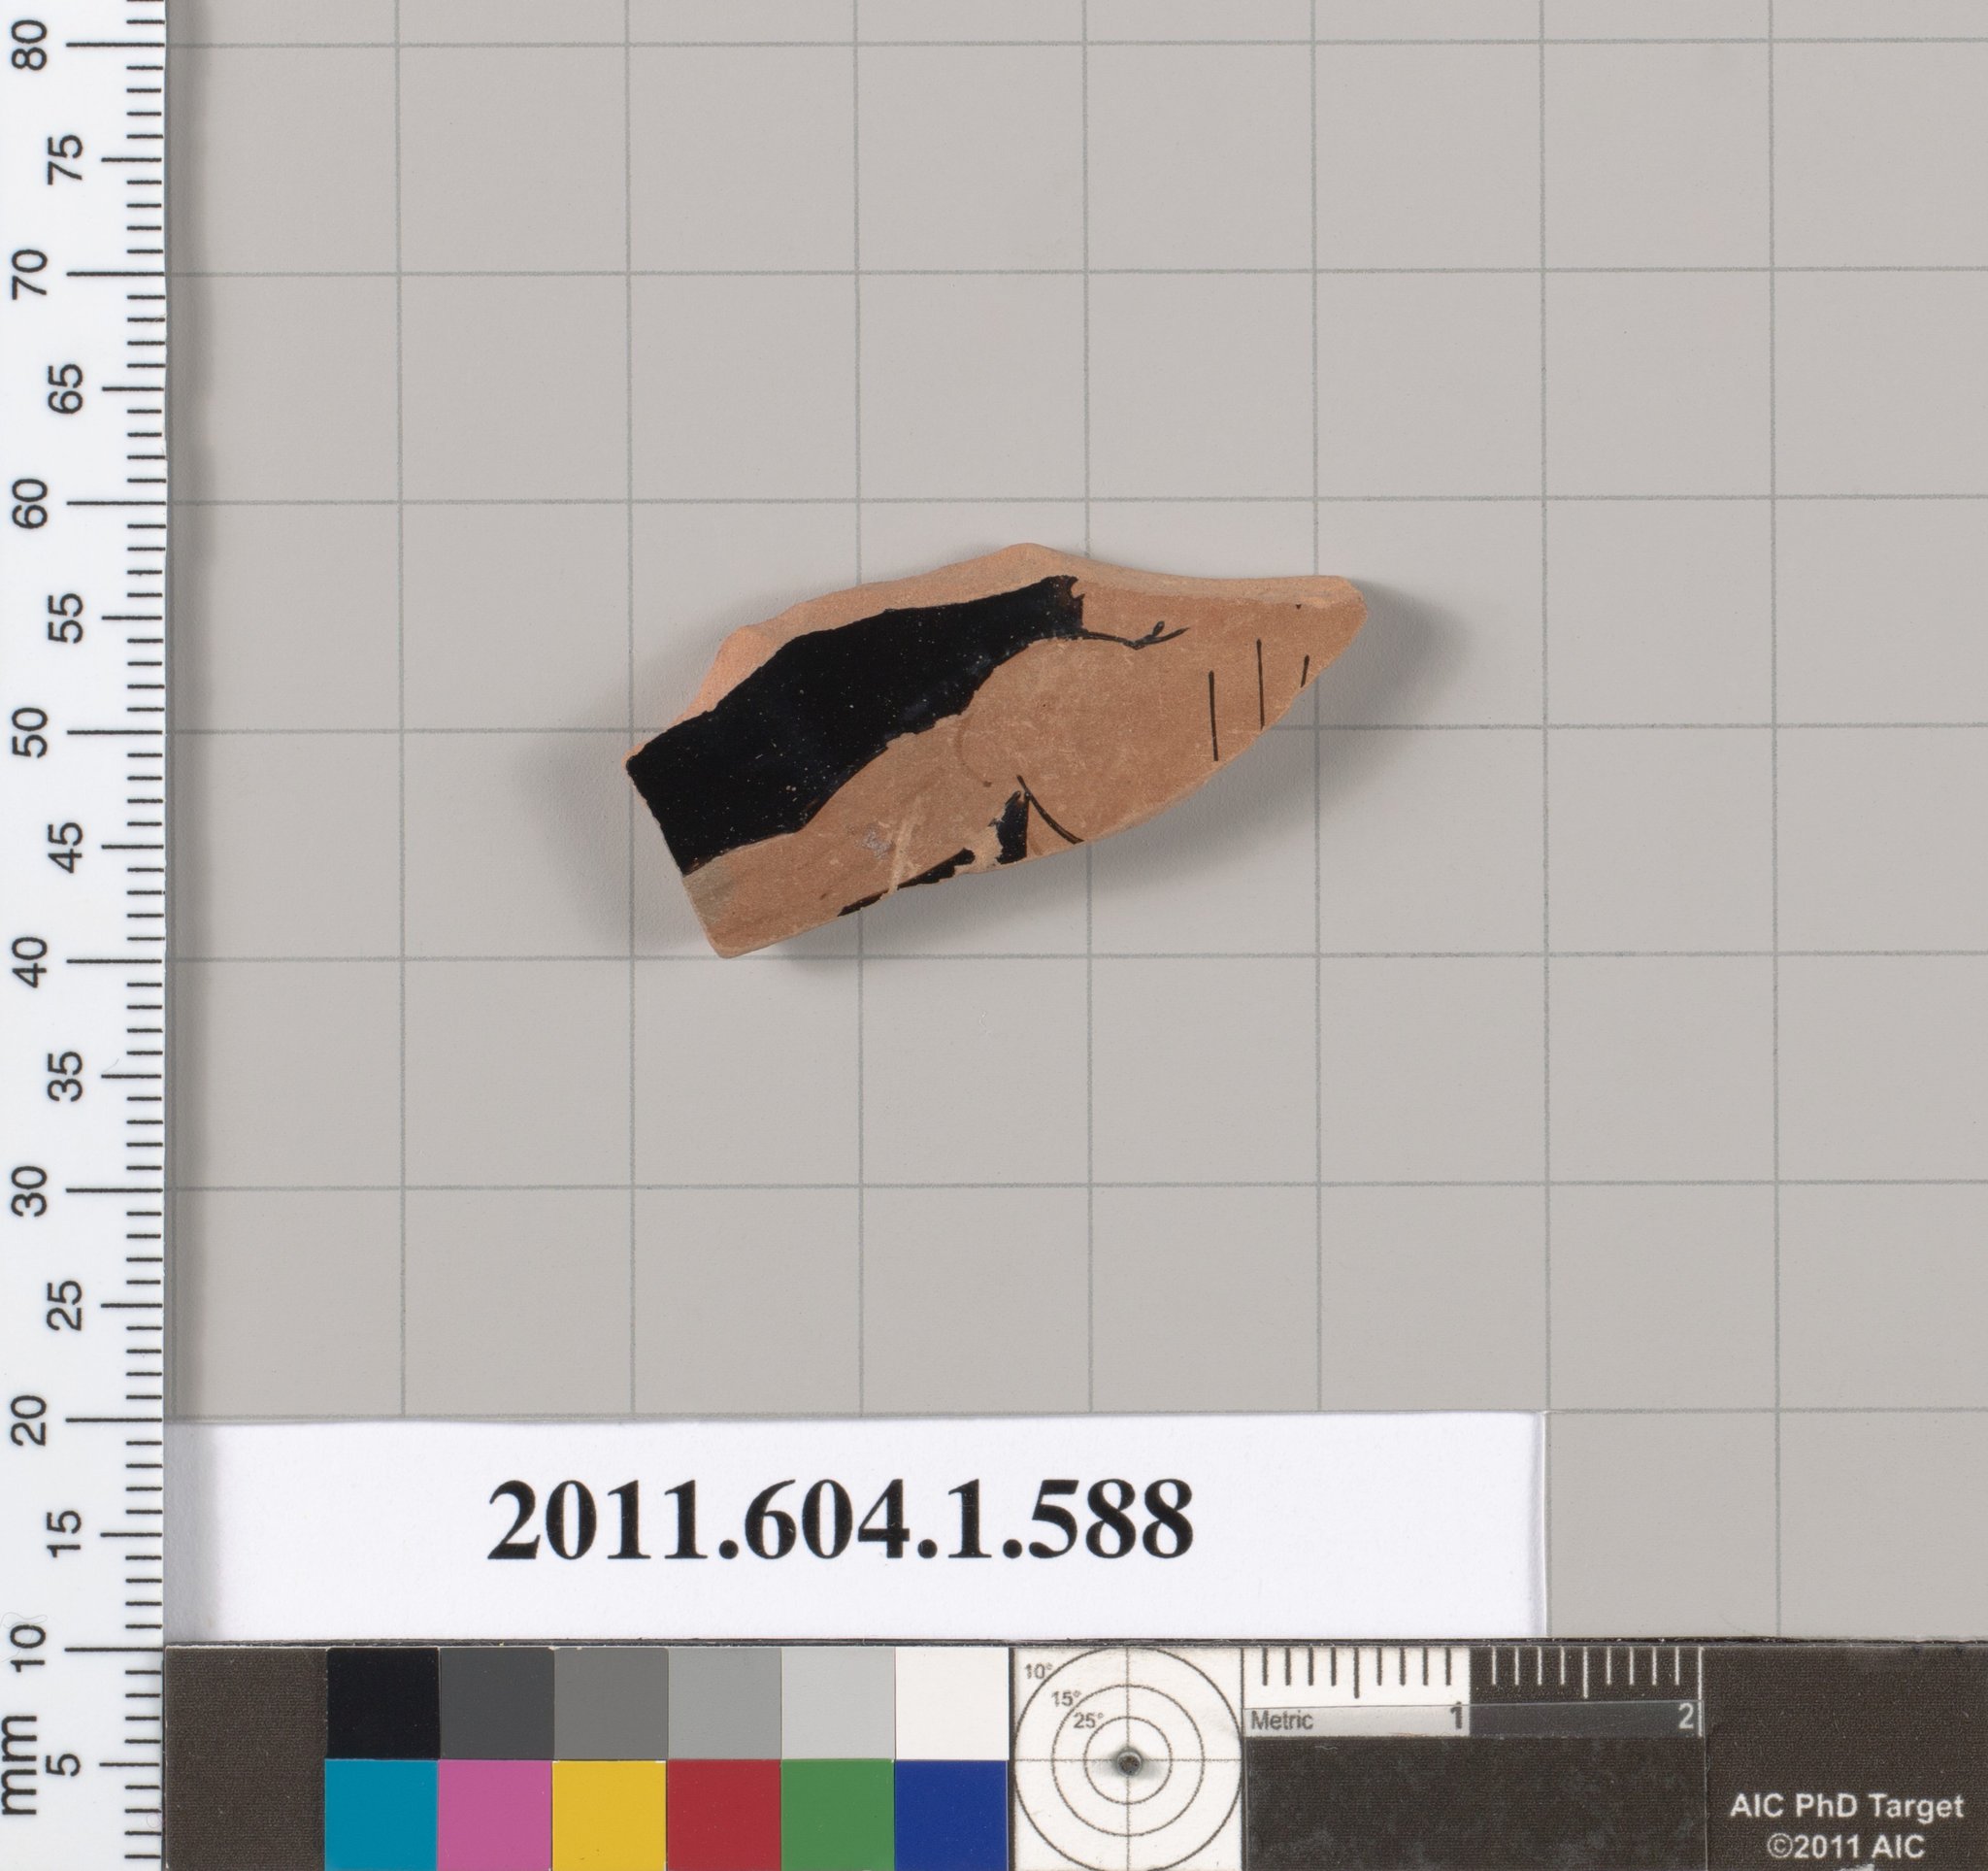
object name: kylix fragment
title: Terracotta fragment of a kylix (drinking cup)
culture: greek, attic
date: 475-451 BCE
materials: terracotta